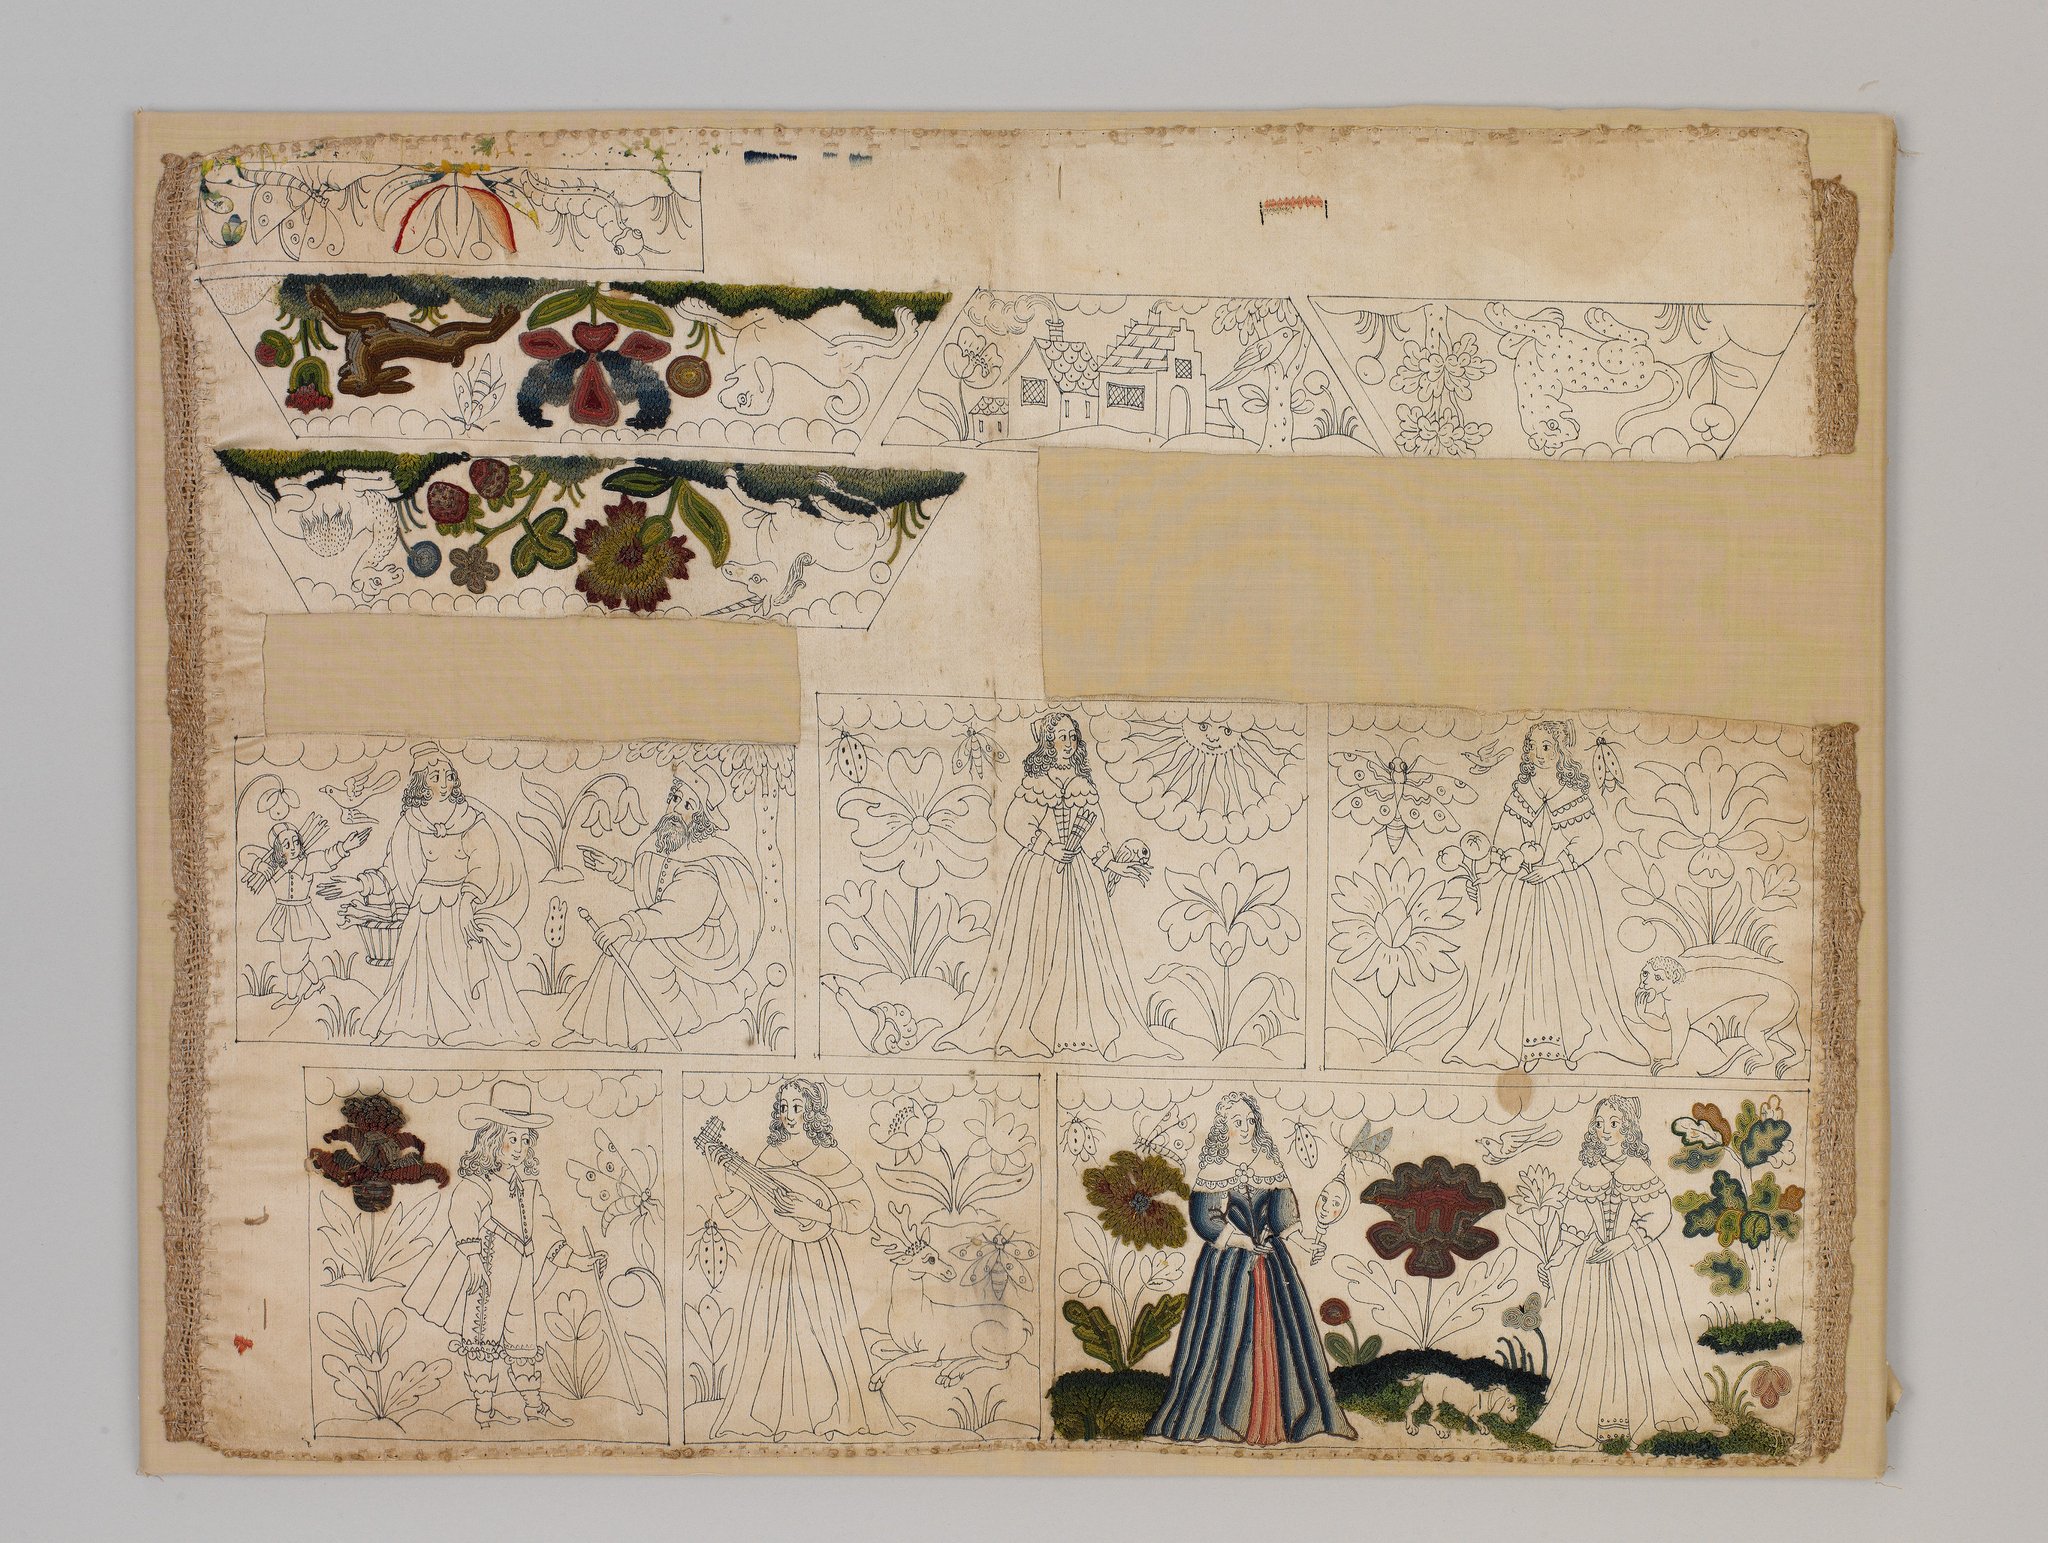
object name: cabinet panel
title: Unfinished cabinet panels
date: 1660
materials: ink, linen, metal thread, pigment, textile, silk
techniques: embroidery, stitching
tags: musical instruments,men,women,flowers